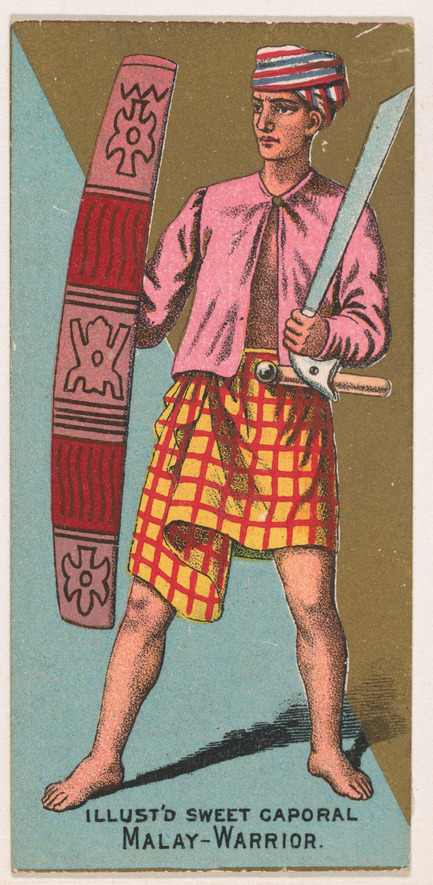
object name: print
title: Malay Warrior, from the Military Series (N224) issued by Kinney Tobacco Company to promote Sweet Caporal Cigarettes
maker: kinney brothers tobacco company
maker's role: publisher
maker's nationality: american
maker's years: 1869-2011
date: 1888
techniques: color lithograph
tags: military,shields,weapons,men